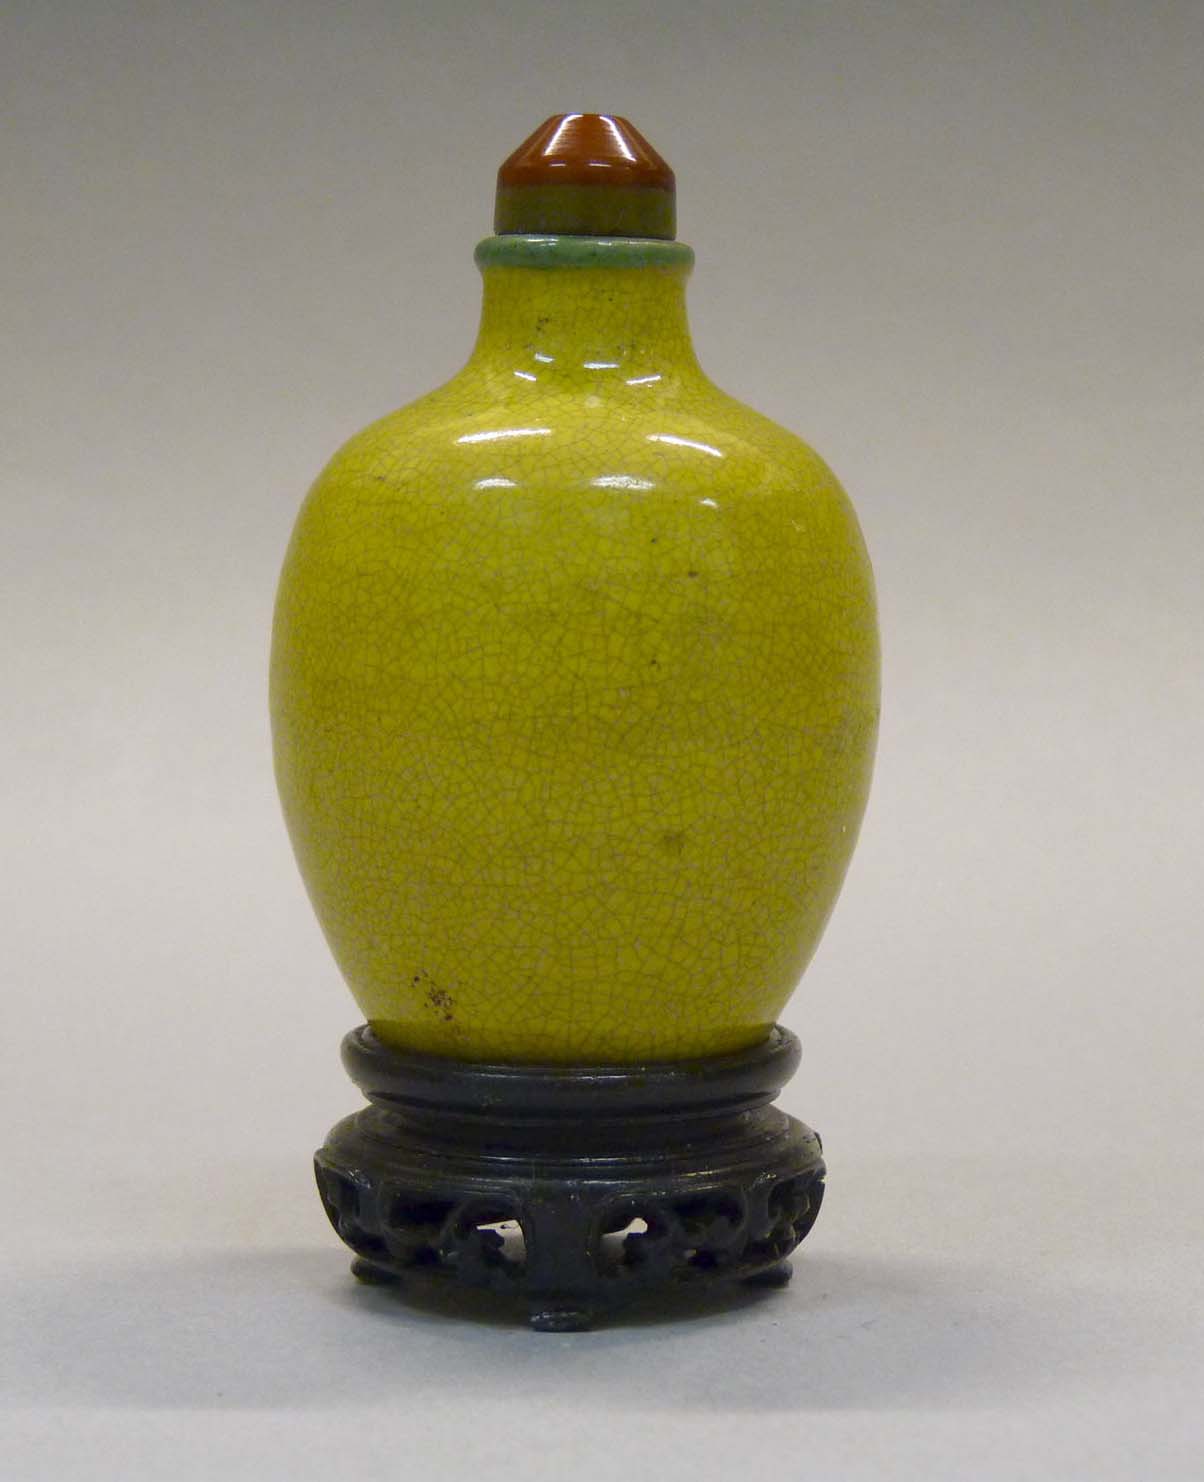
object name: snuff bottle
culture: chinese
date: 1736-1795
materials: amber, porcelain